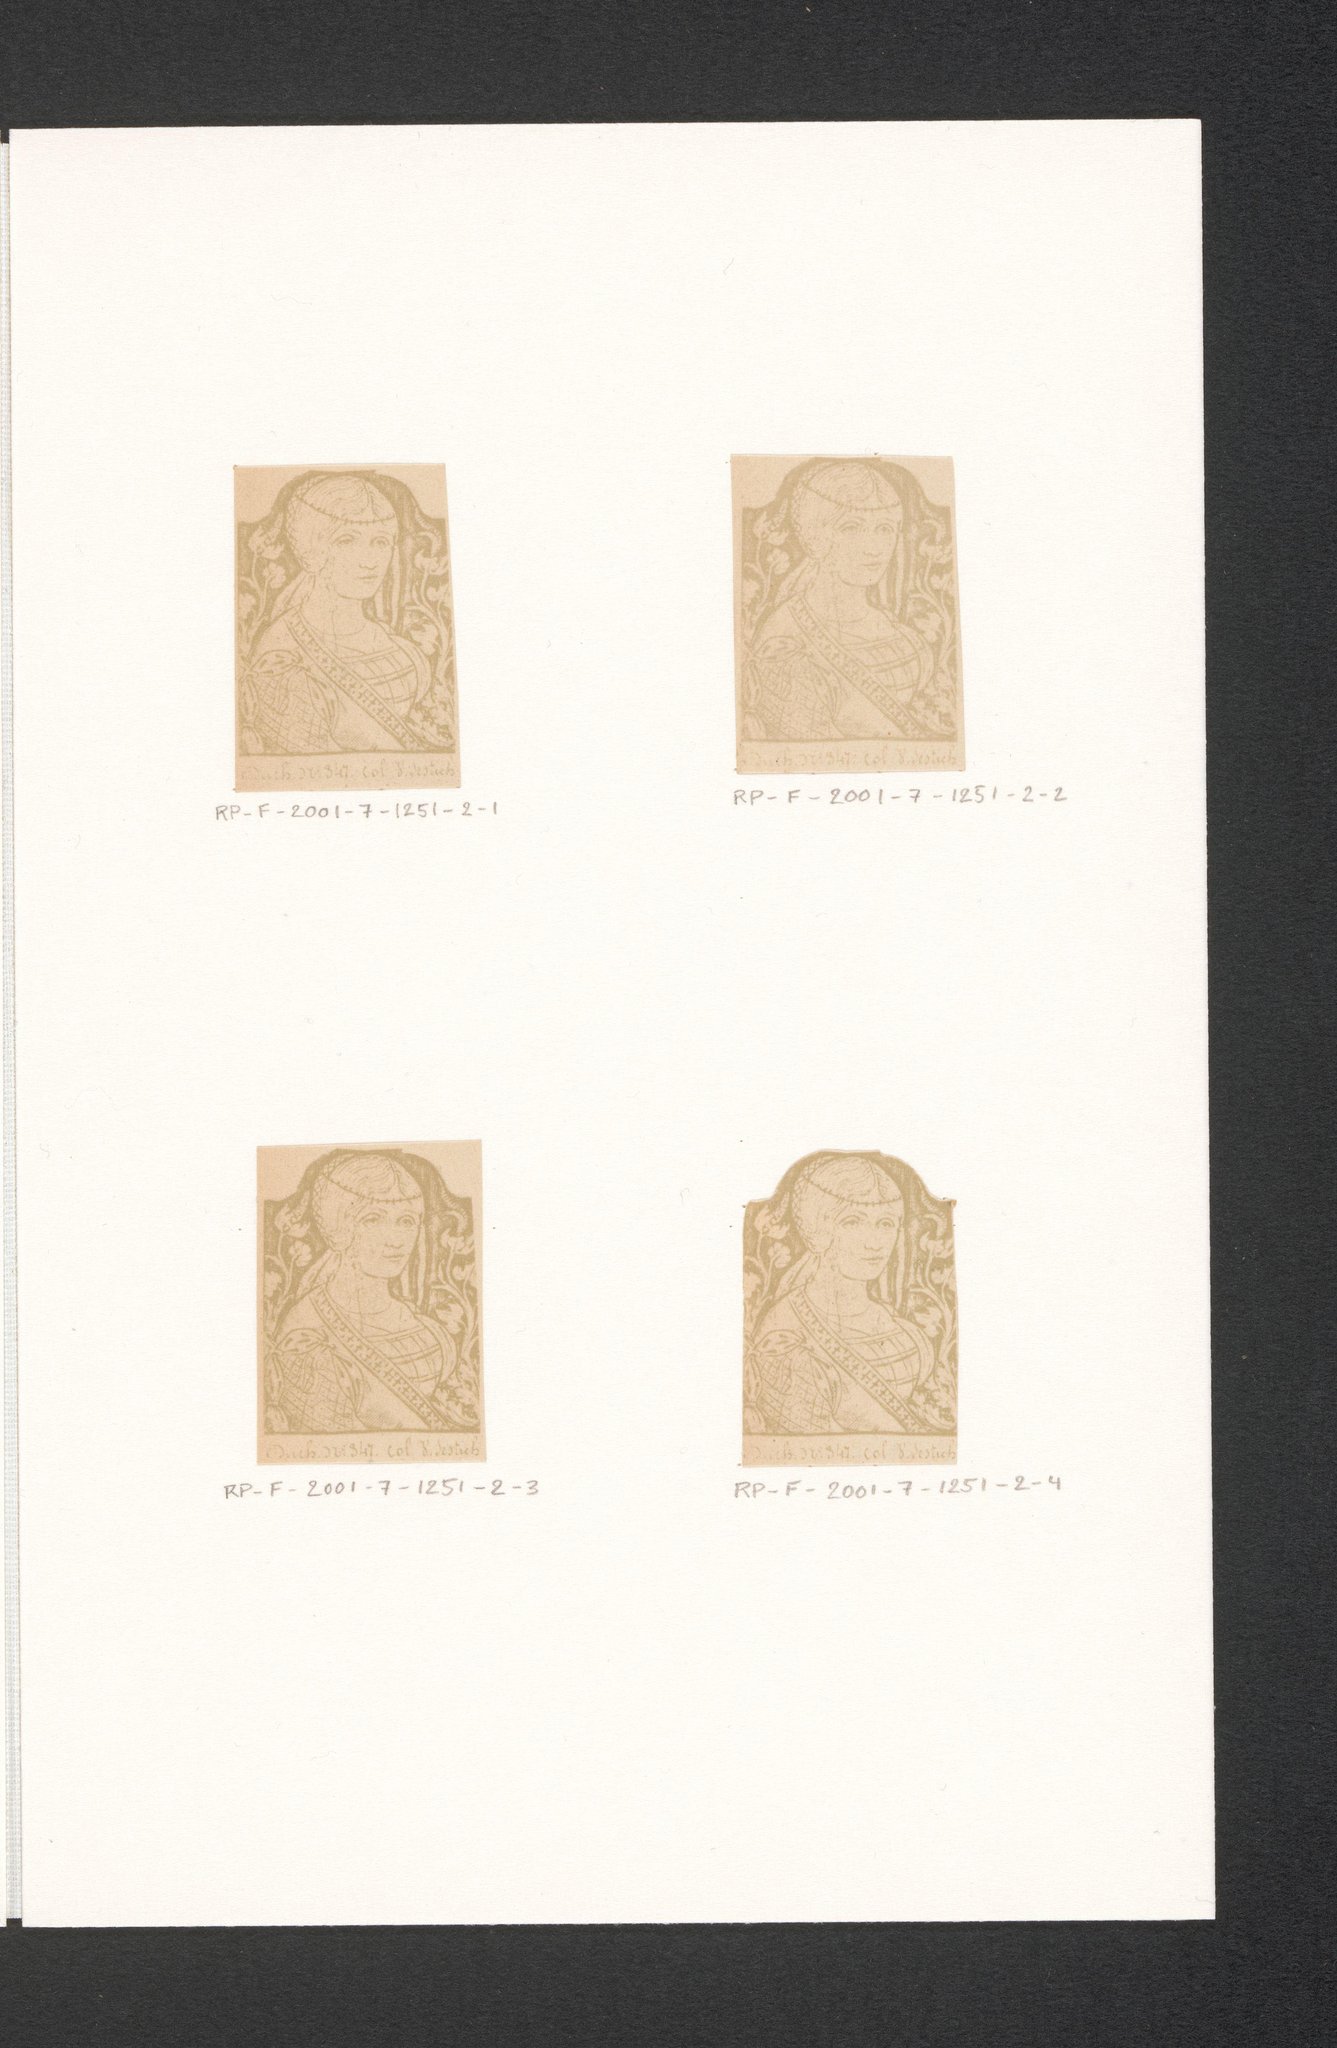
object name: page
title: Fotoreproductie van een prent van een portret van een onbekende vrouw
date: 1852-1857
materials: photographic support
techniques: salted paper print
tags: historical persons not known by name - bb - woman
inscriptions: inscription: ‘[Du]ch. No 347. col. V. Sestich’